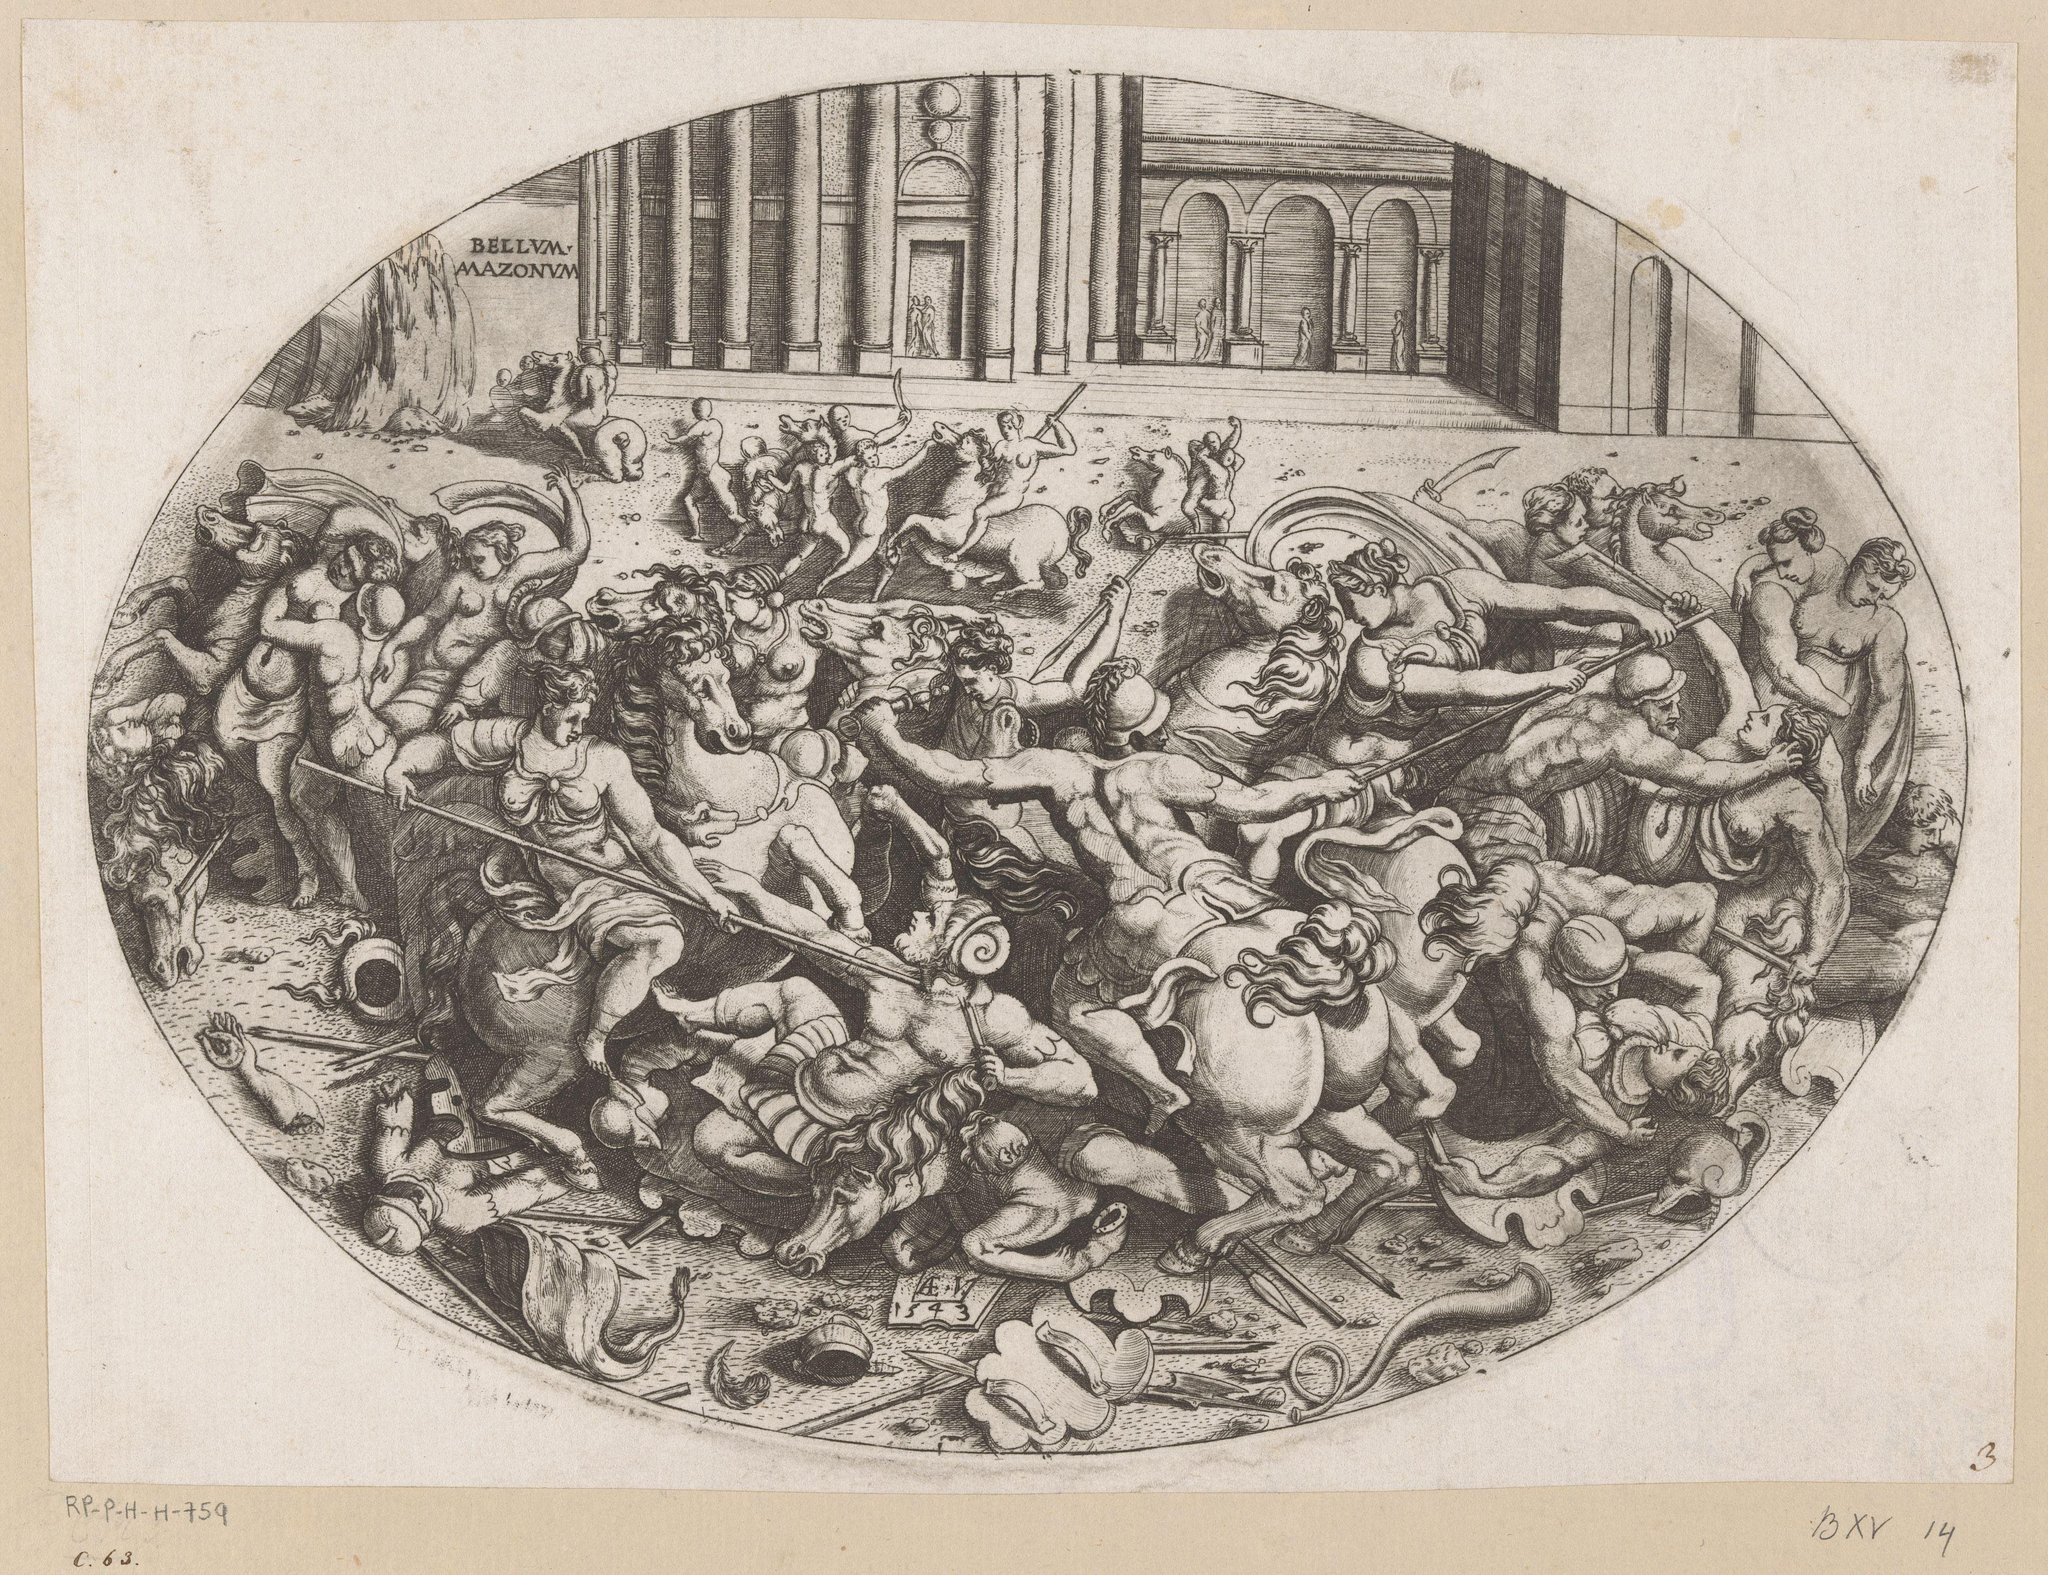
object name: print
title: Amazonenslag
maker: enea vico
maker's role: draughtsman, print maker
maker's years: 1523-1567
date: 1543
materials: paper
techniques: engraving, etching, intaglio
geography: italy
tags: battle of amazons; amazonomachy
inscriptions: collector's mark: Lugt 10, collector's mark: Lugt 11, collector's mark: ‘Hinloopen’, number: ‘3’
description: Strijdscène tussen de krijgshaftige halfnaakte Amazonen en mannelijke soldaten met helmen. Titel linksboven.